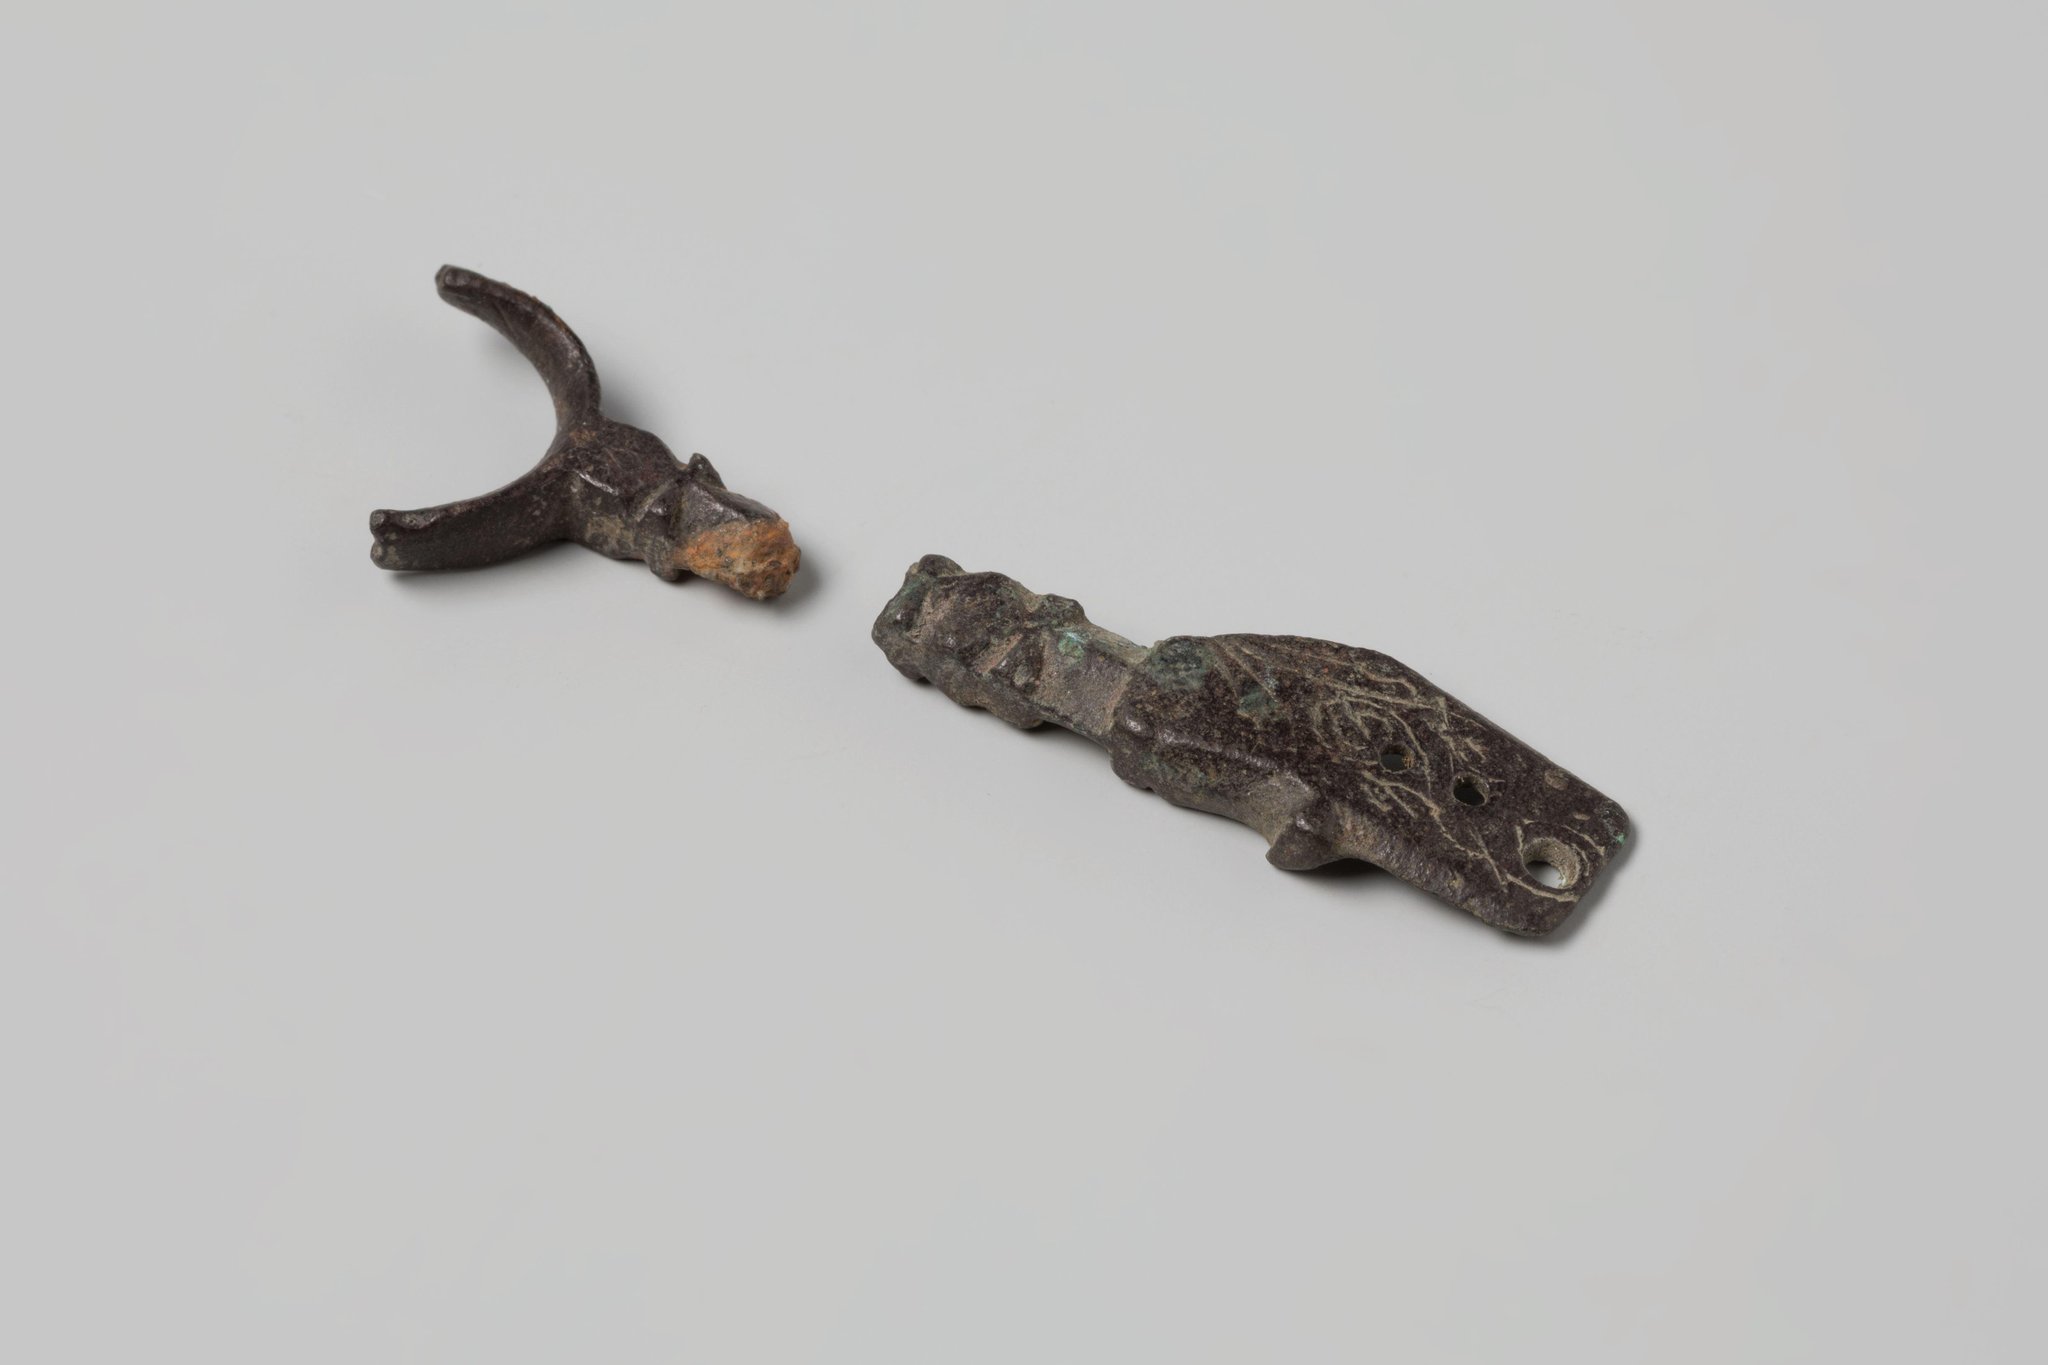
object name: pin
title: Fragmenten spelden uit het wrak van de Oost-Indiëvaarder Hollandia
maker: Anonymous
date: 1700-1743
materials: copper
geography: netherlands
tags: verenigde oostindische compagnie, hollandia (schip), annet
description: Tools and instruments, sewing and sailmaking, pin; fragm, shaft with blade-mount and bow, id. NG 1980-27H3265.